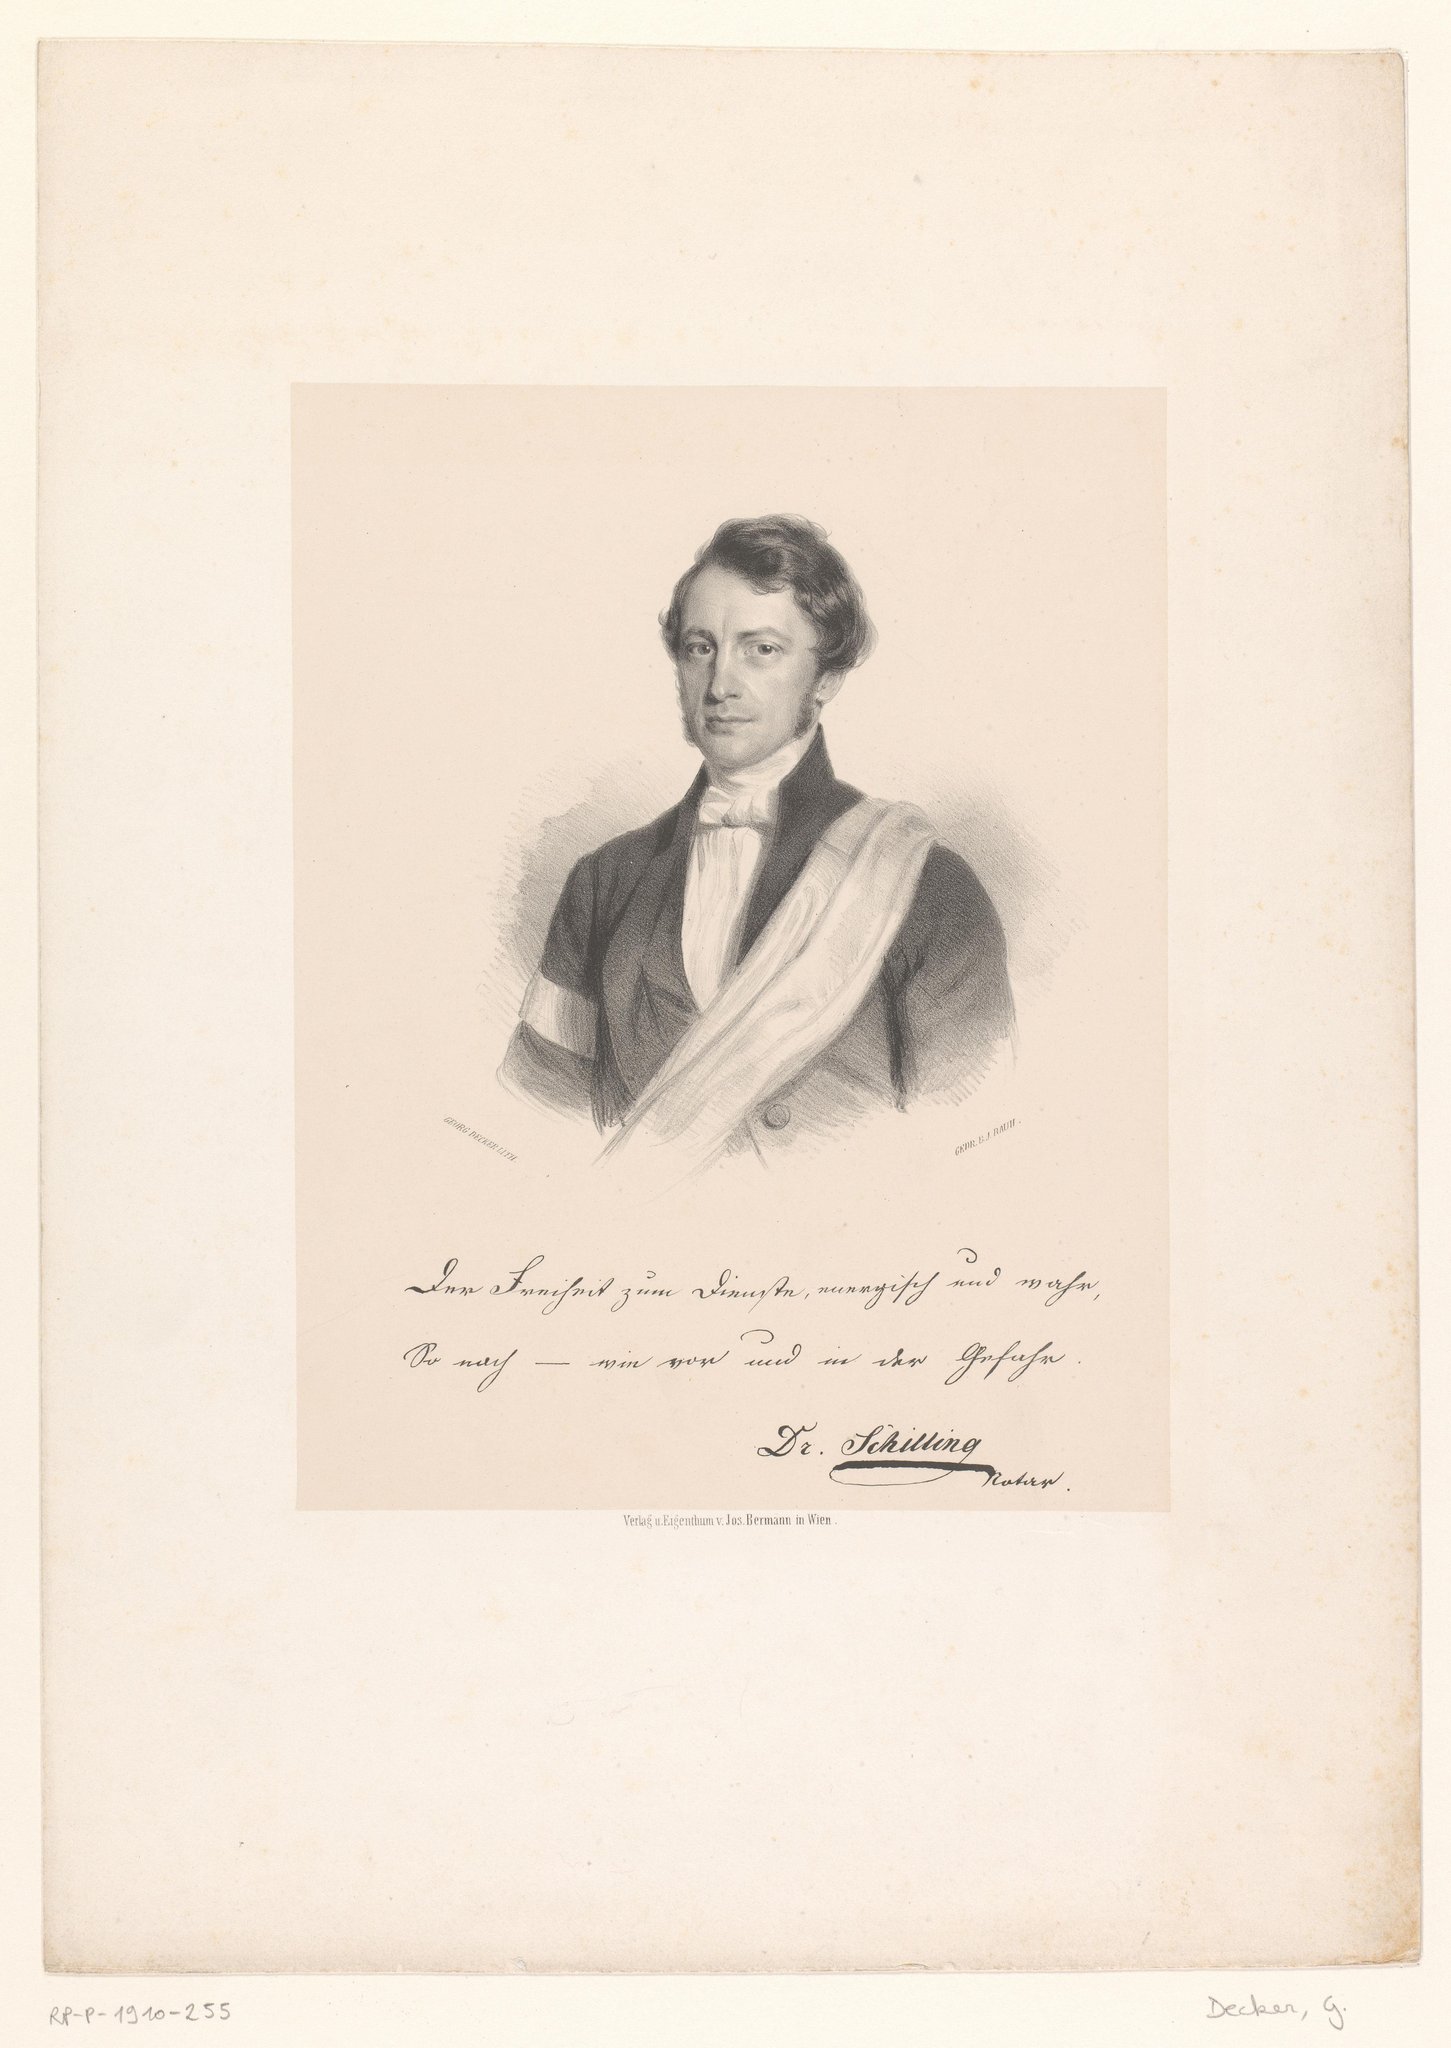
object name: print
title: Portret van Ernst Schilling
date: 1829-1860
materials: paper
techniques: lithograph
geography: vienna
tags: politician, adult man, historical persons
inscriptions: collector's mark: Lugt 2228